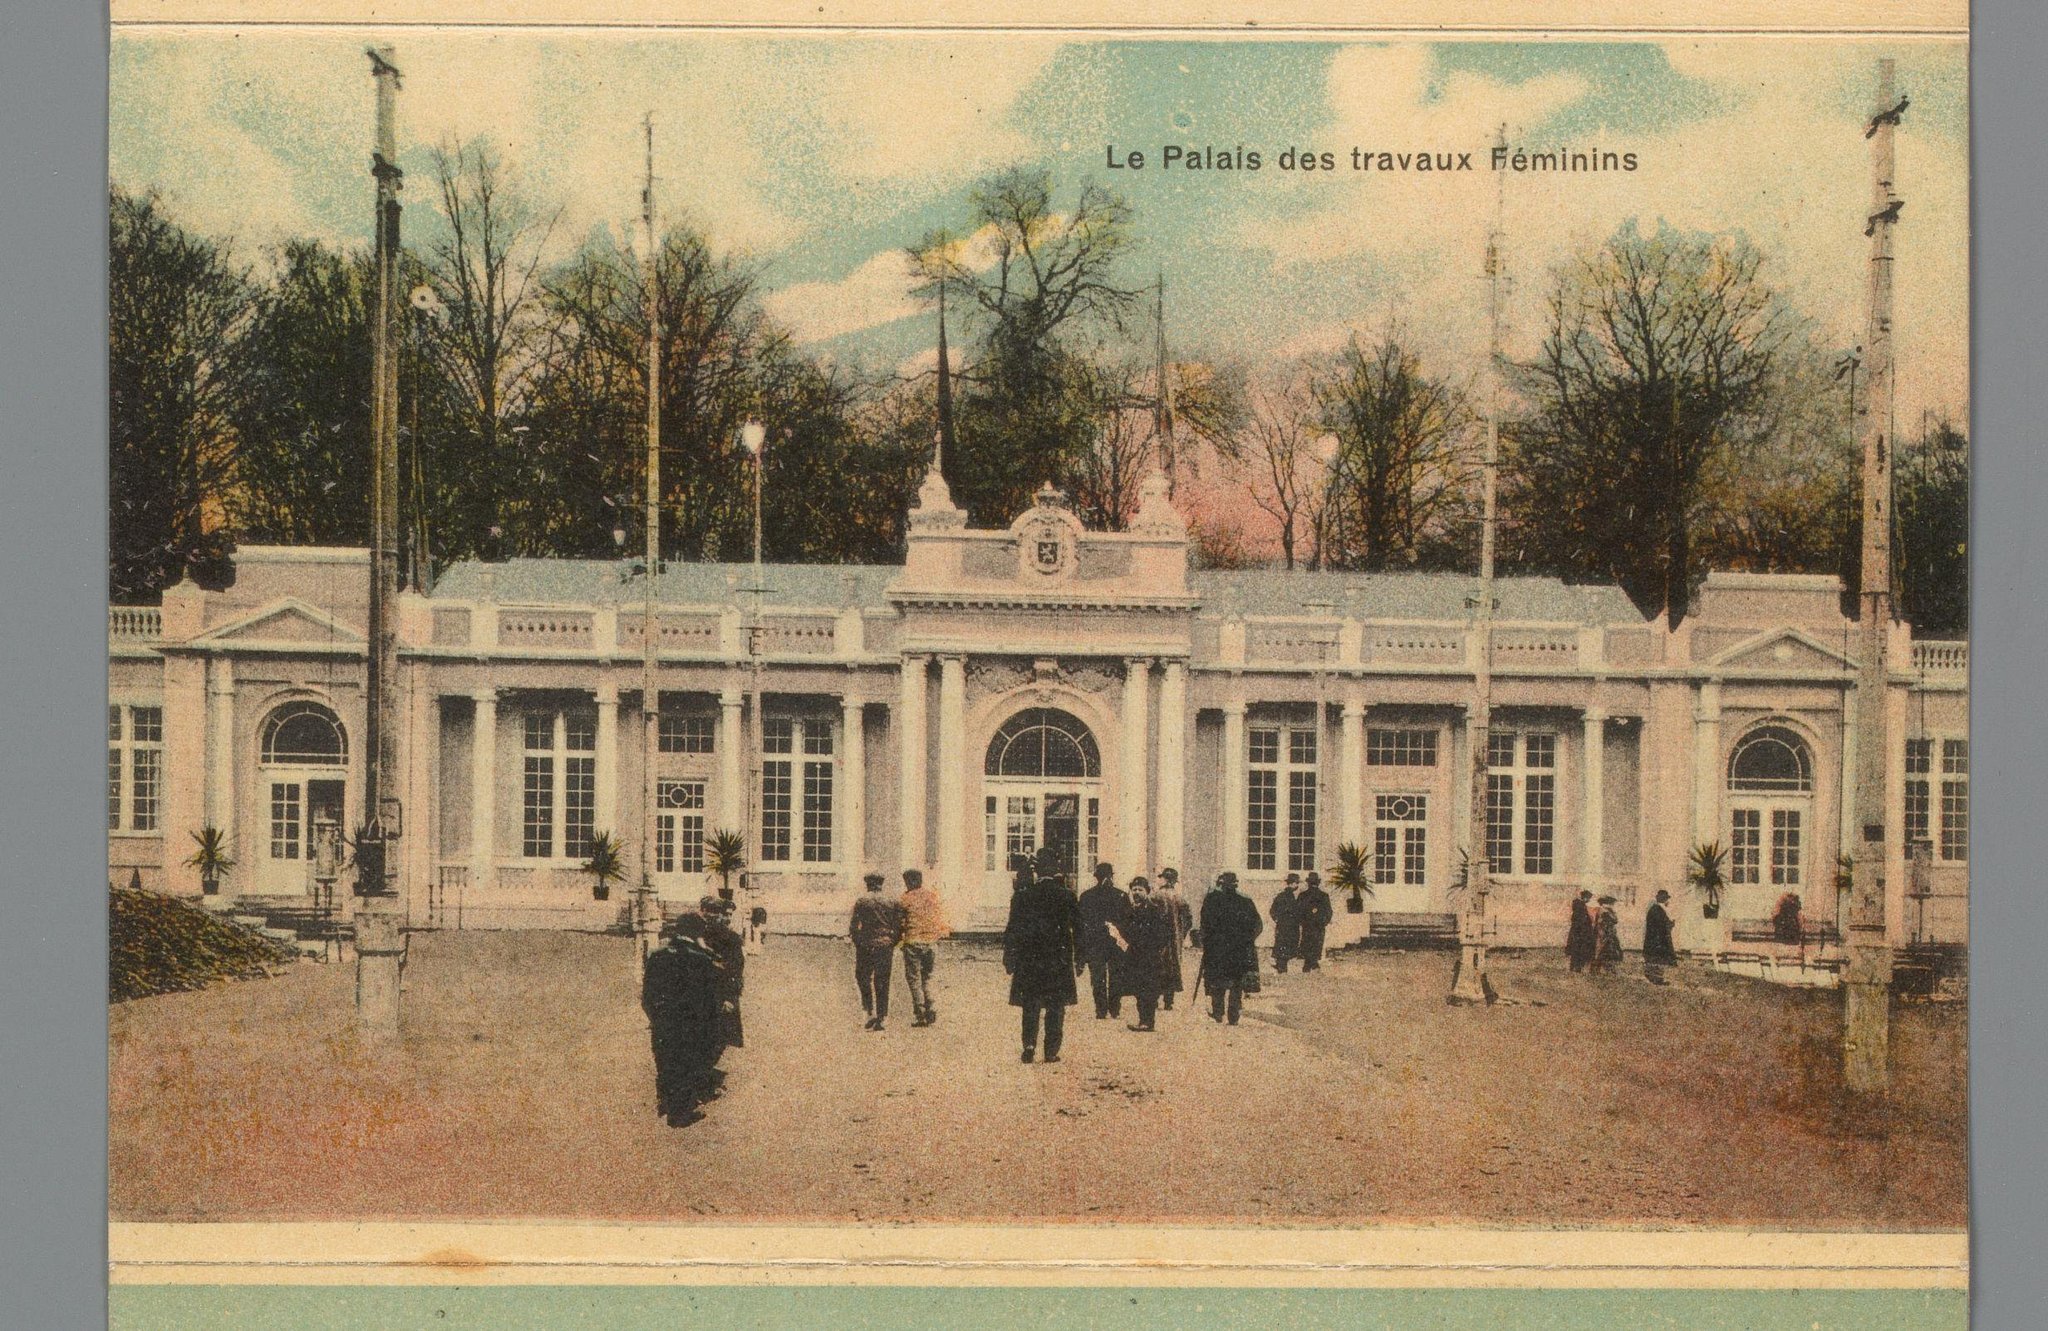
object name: ansichtkaart, prentbriefkaart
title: Le Palais des travaux féminins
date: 1910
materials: cardboard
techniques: photograph, lithograph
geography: brussels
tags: world fair, world exhibition, edifice, e.g.: public building, department store, brussels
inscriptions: date